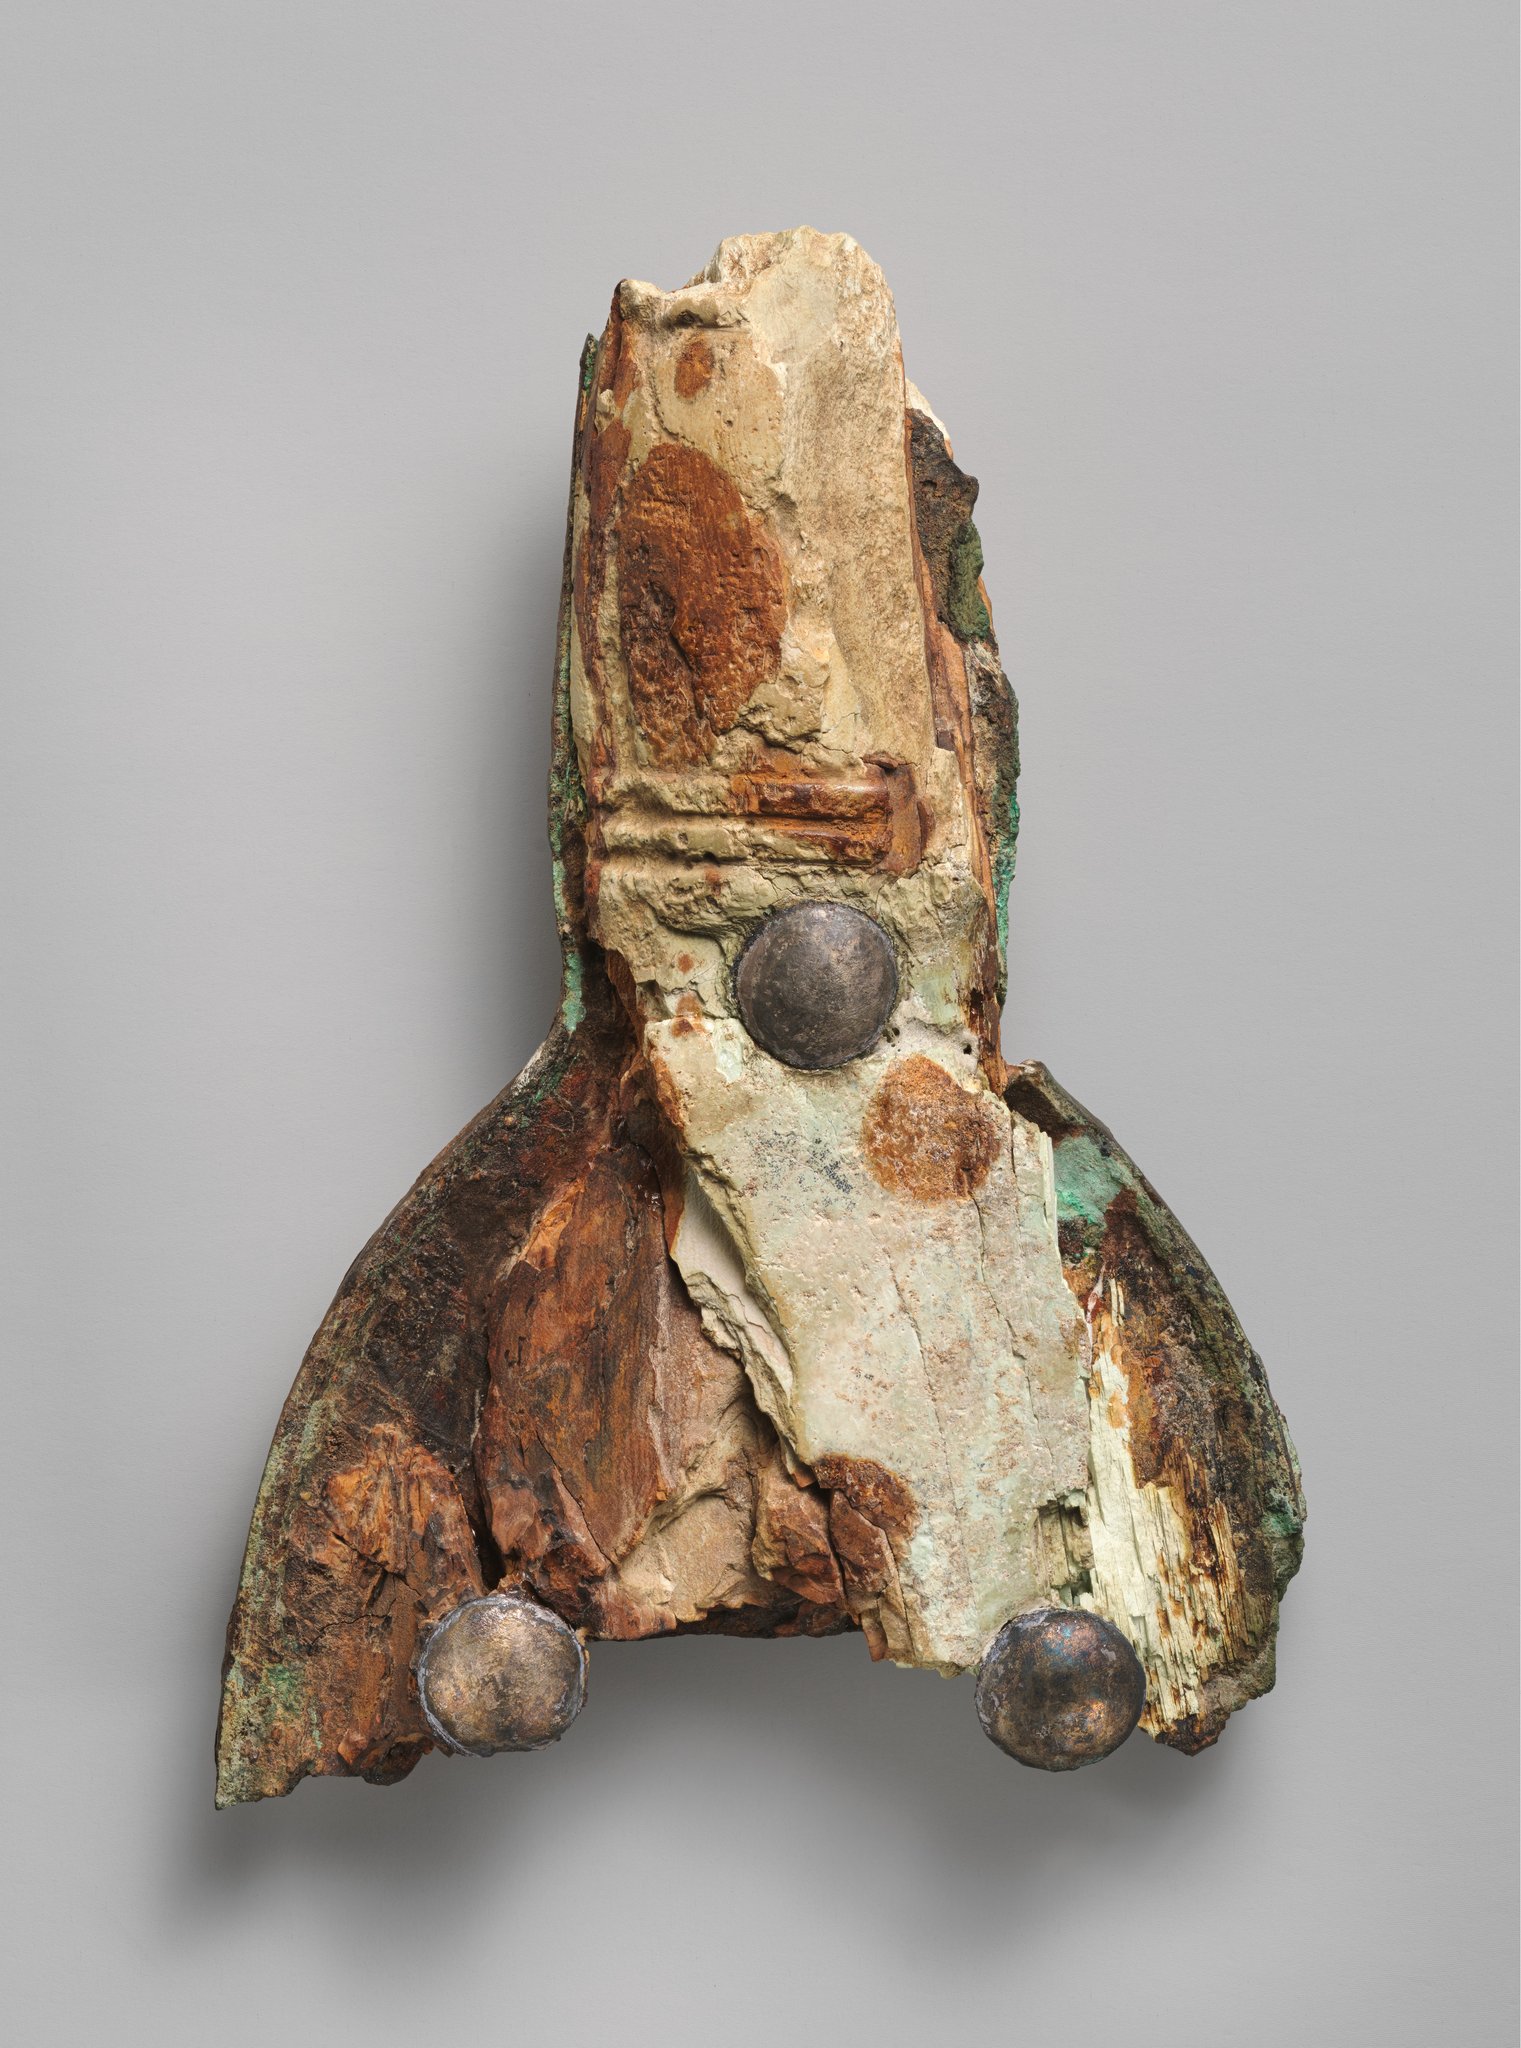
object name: sword fragment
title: Iron hilt of a sword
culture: cypriot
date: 700-601 BCE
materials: bronze, iron, ivory, silver